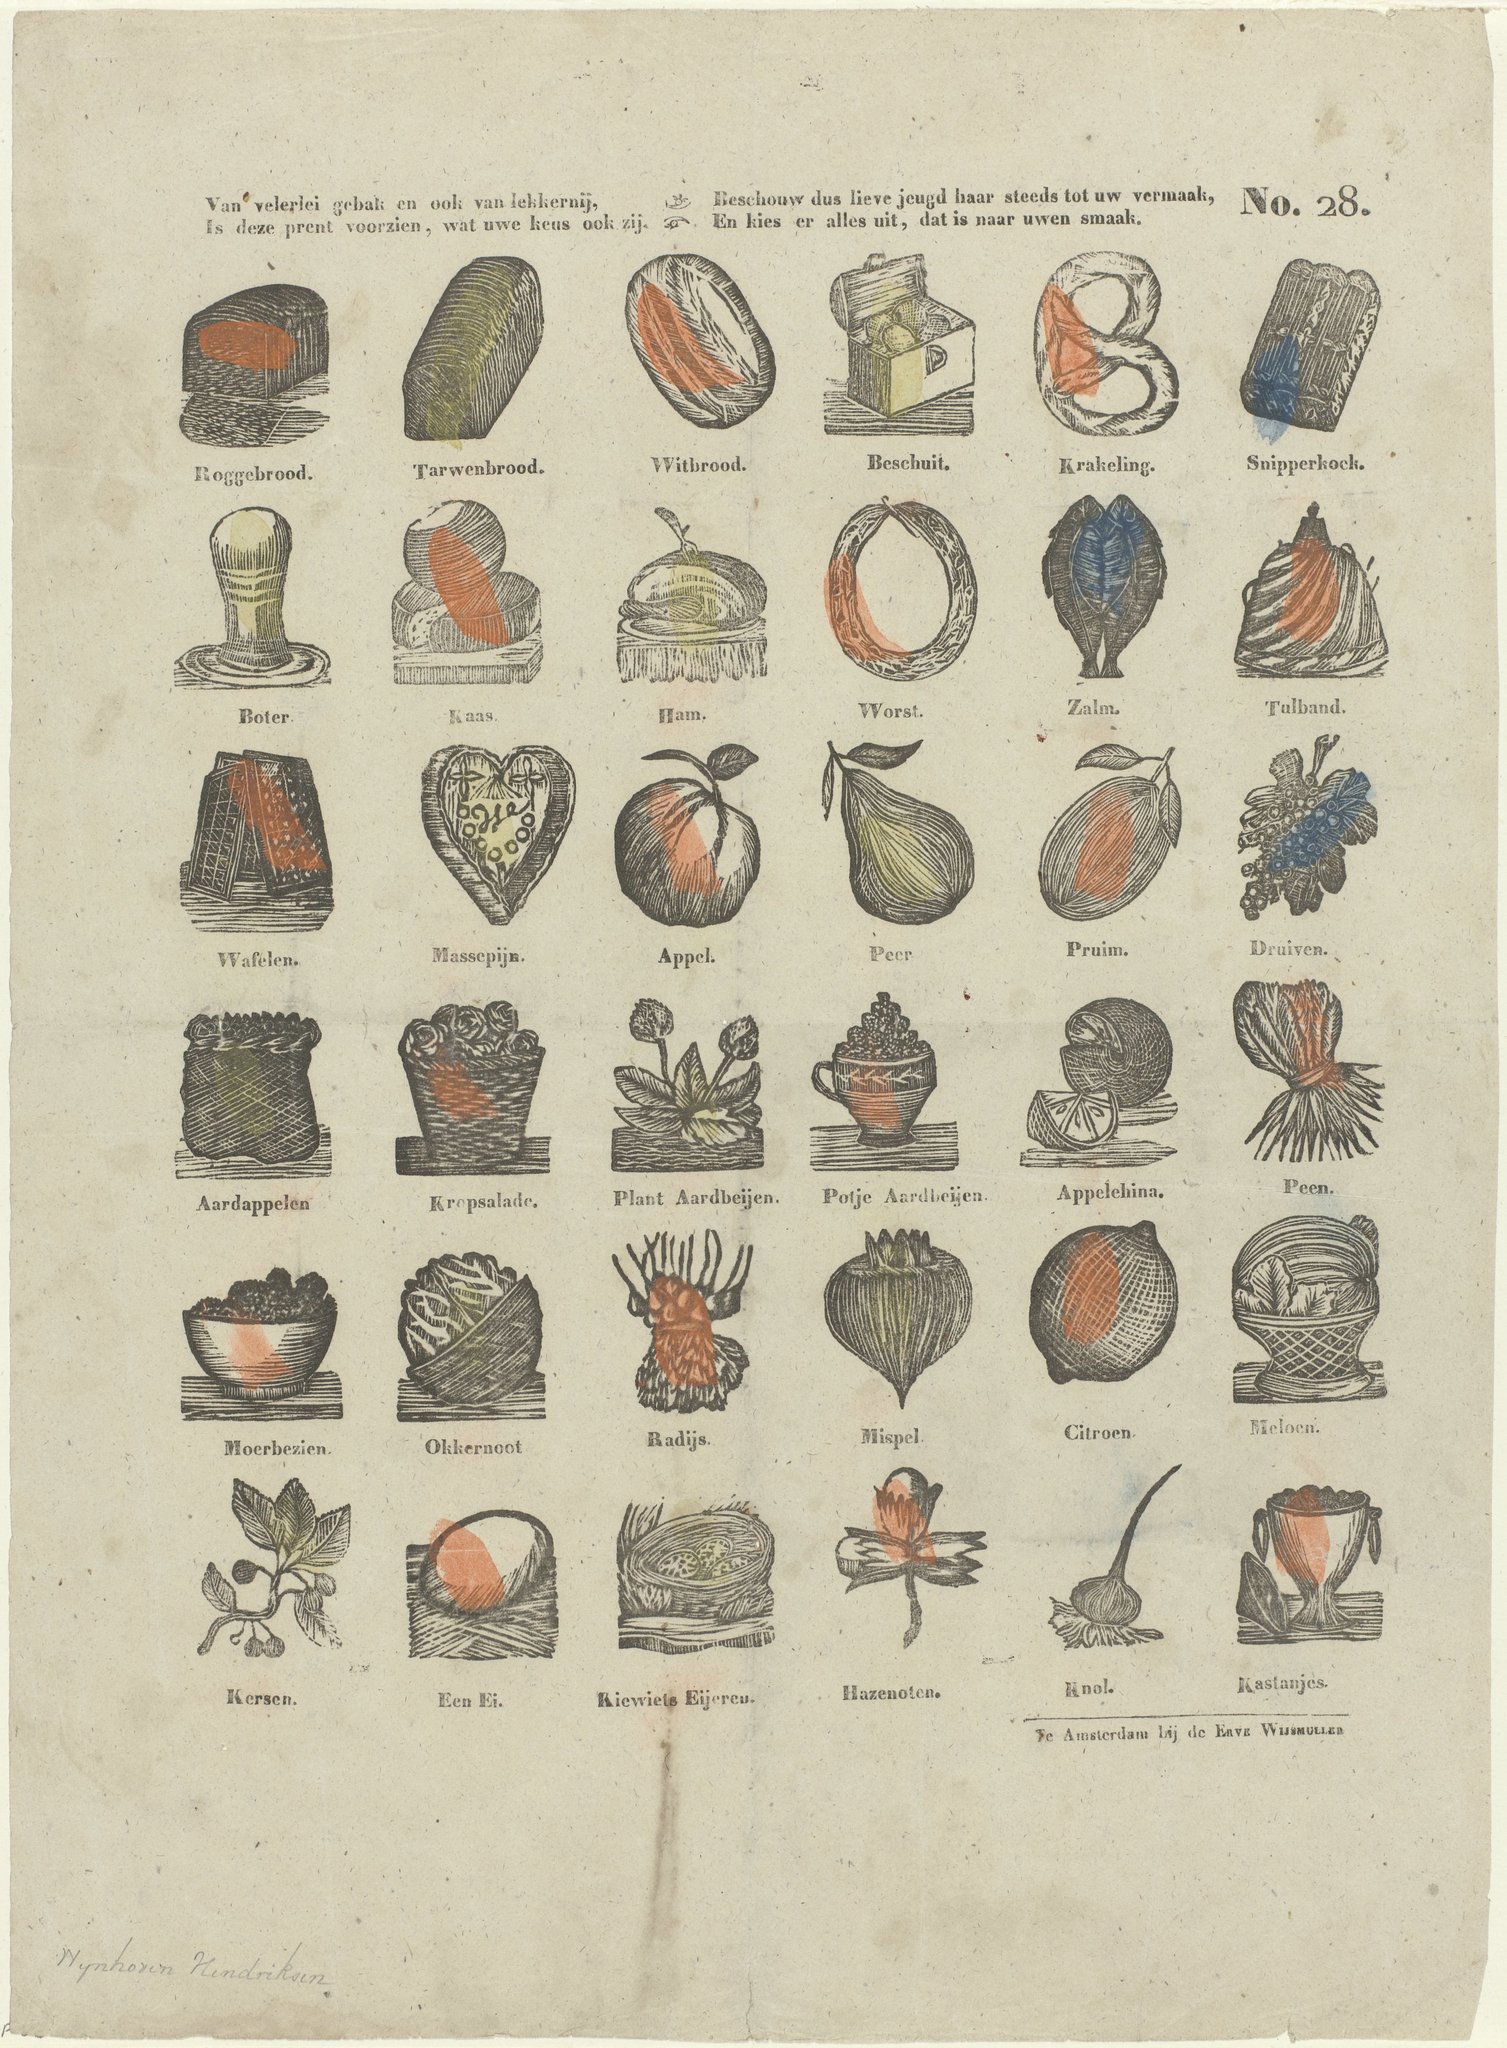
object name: popular print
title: Van velerlei gebak en ook van lekkernij / Is deze prent voorzien, wat uwe keus ook zij. / Beschouw dus lieve jeugd haar steeds tot uw vermaak, / En kies er alles uit, dat is naar uwen smaak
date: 1832-1850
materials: paper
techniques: colour, letterpress printing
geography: rotterdam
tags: vegetables, cake, tart, pastry, bread, loaf, fruits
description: Blad met 36 voorstellingen van etenswaren, zoals roggebrood, zalm, peer en knol. Onder elke voorstelling een onderschrift. Genummerd rechtsboven: No. 28.